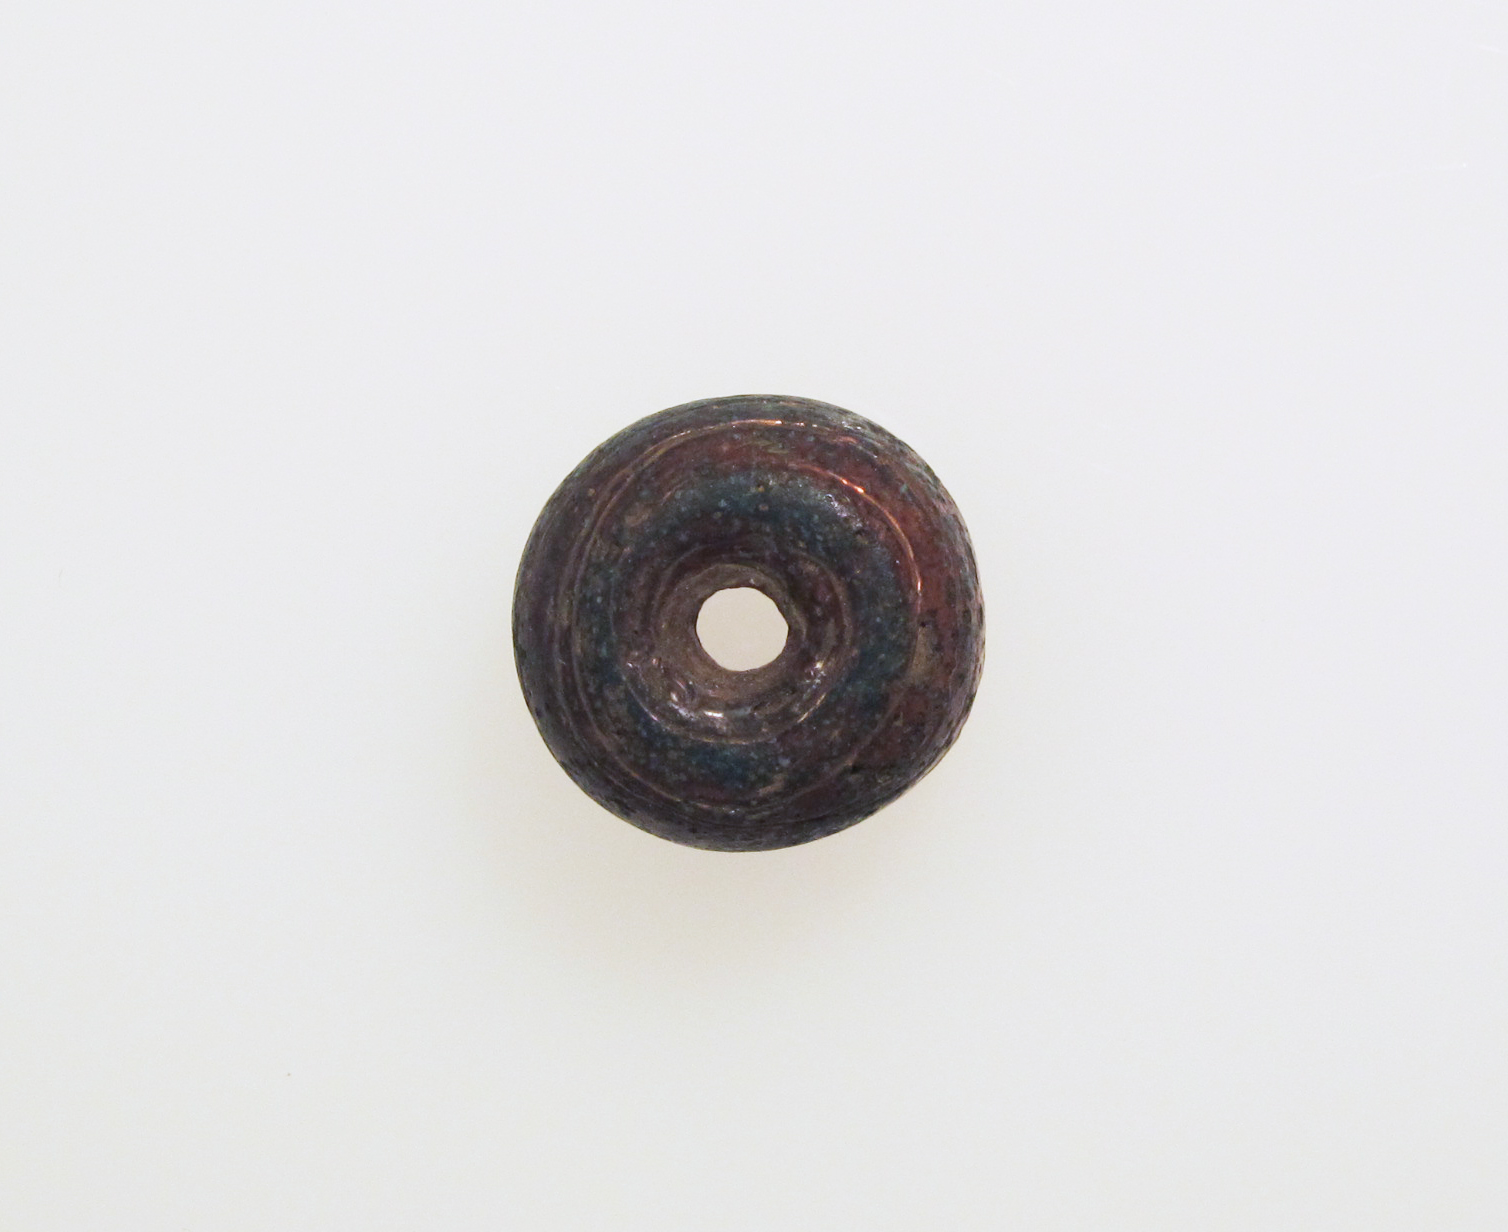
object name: bead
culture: roman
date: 670 BCE-330 CE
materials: glass